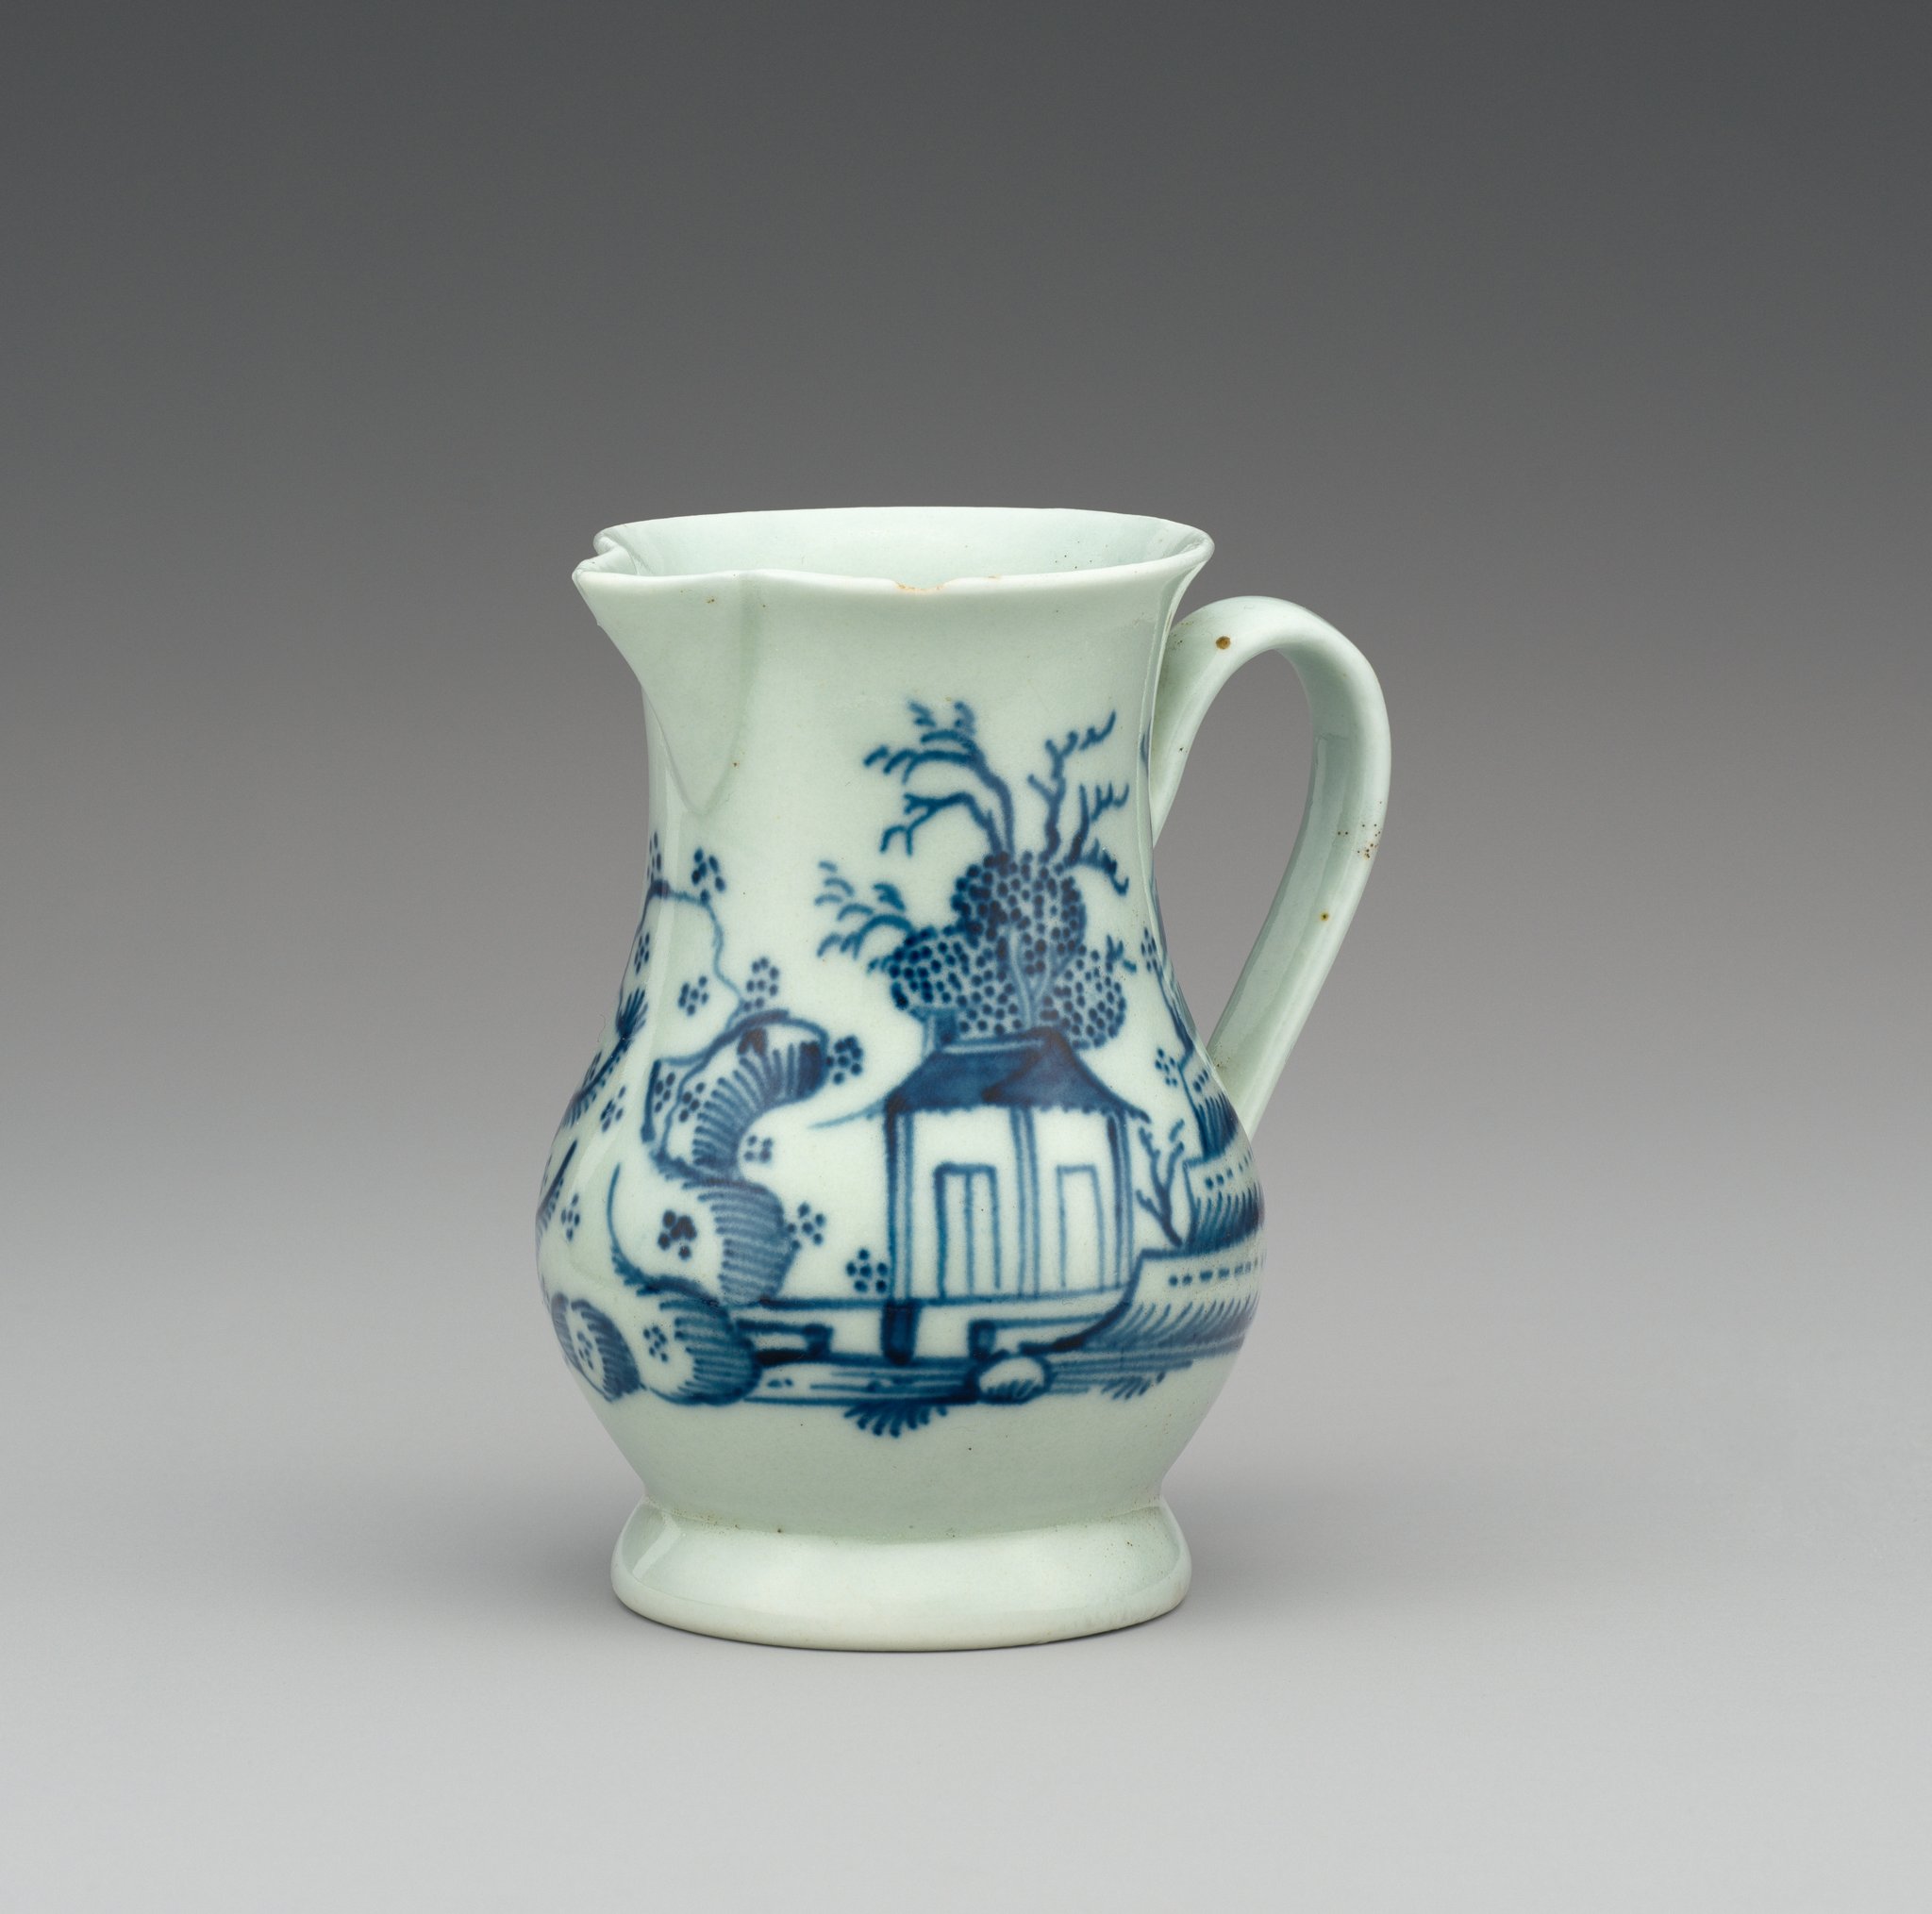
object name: cream jug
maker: liverpool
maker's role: factory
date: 1770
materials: soft paste porcelain